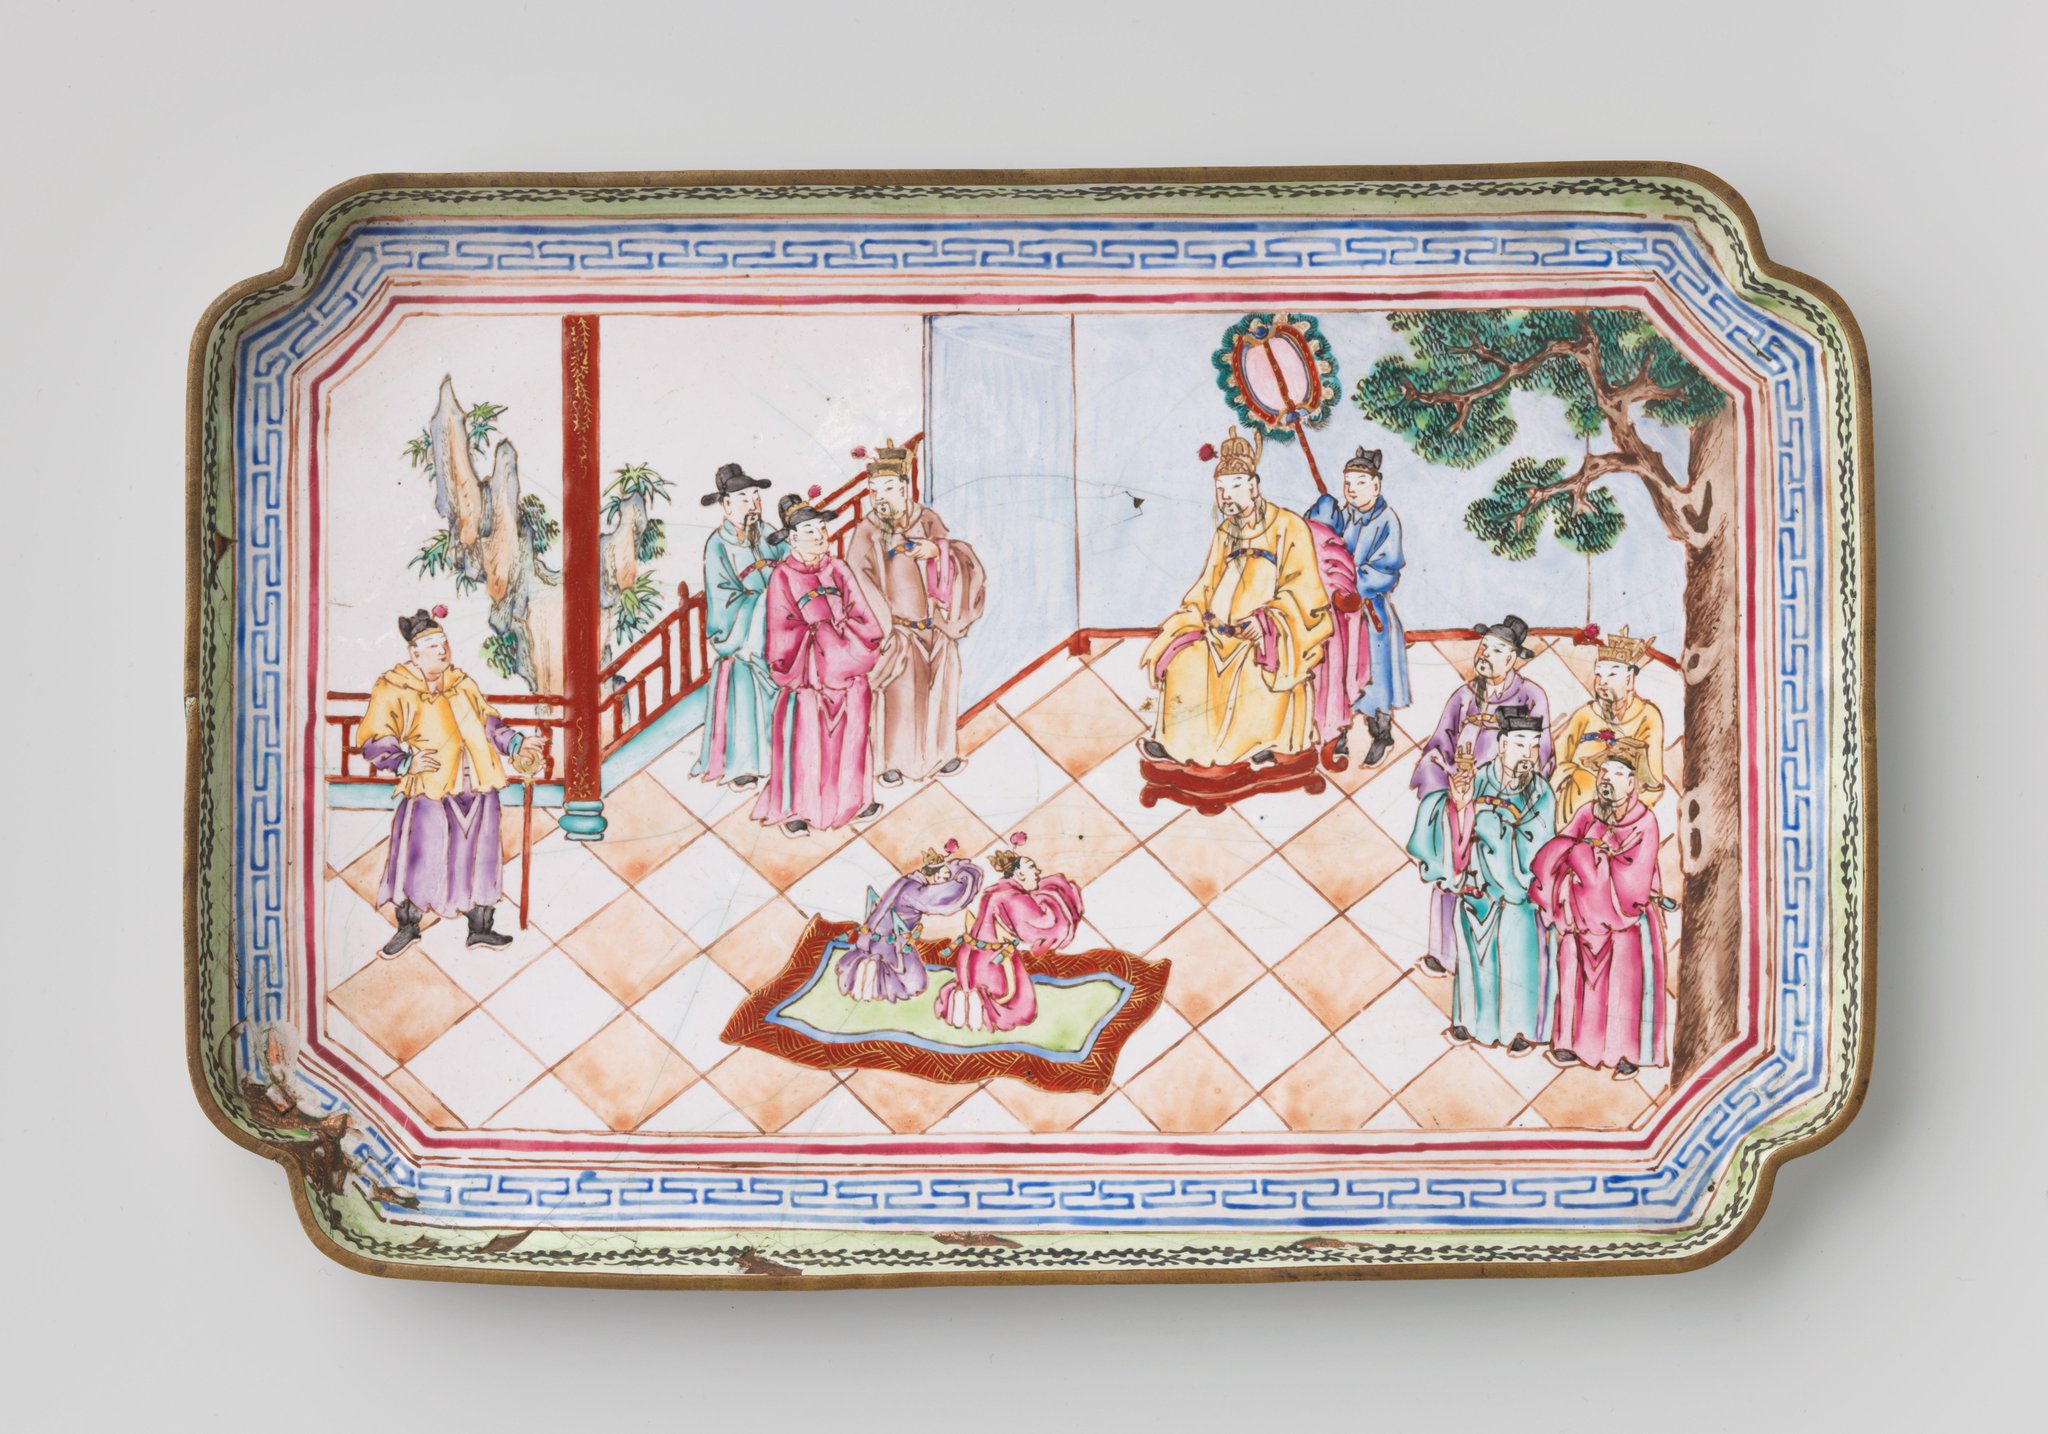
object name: blad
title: Rechthoekig blad met figuren op een terras.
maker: Anonymous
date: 1750-1775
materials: copper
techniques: enamel painting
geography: china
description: Rechthoekig blad met ingenepen hoeken op vier lage voeten. Beschilderdged met figuren op een terras: een hooggeplaatste Chinees zit op een zetel en krijgt met een waaier koelte toegewoven; achter hem een groot kamerscherm. Voor hem knielen twee personen. Ter werszijde staan twee groepen van vier mannen toe te kijken. In de rand een geometreisch patroon en een zeer gestileerde bladrank. Op de opstaande buitenrand een cracked ice-motief en op de bodem een paddestoel in blauw.